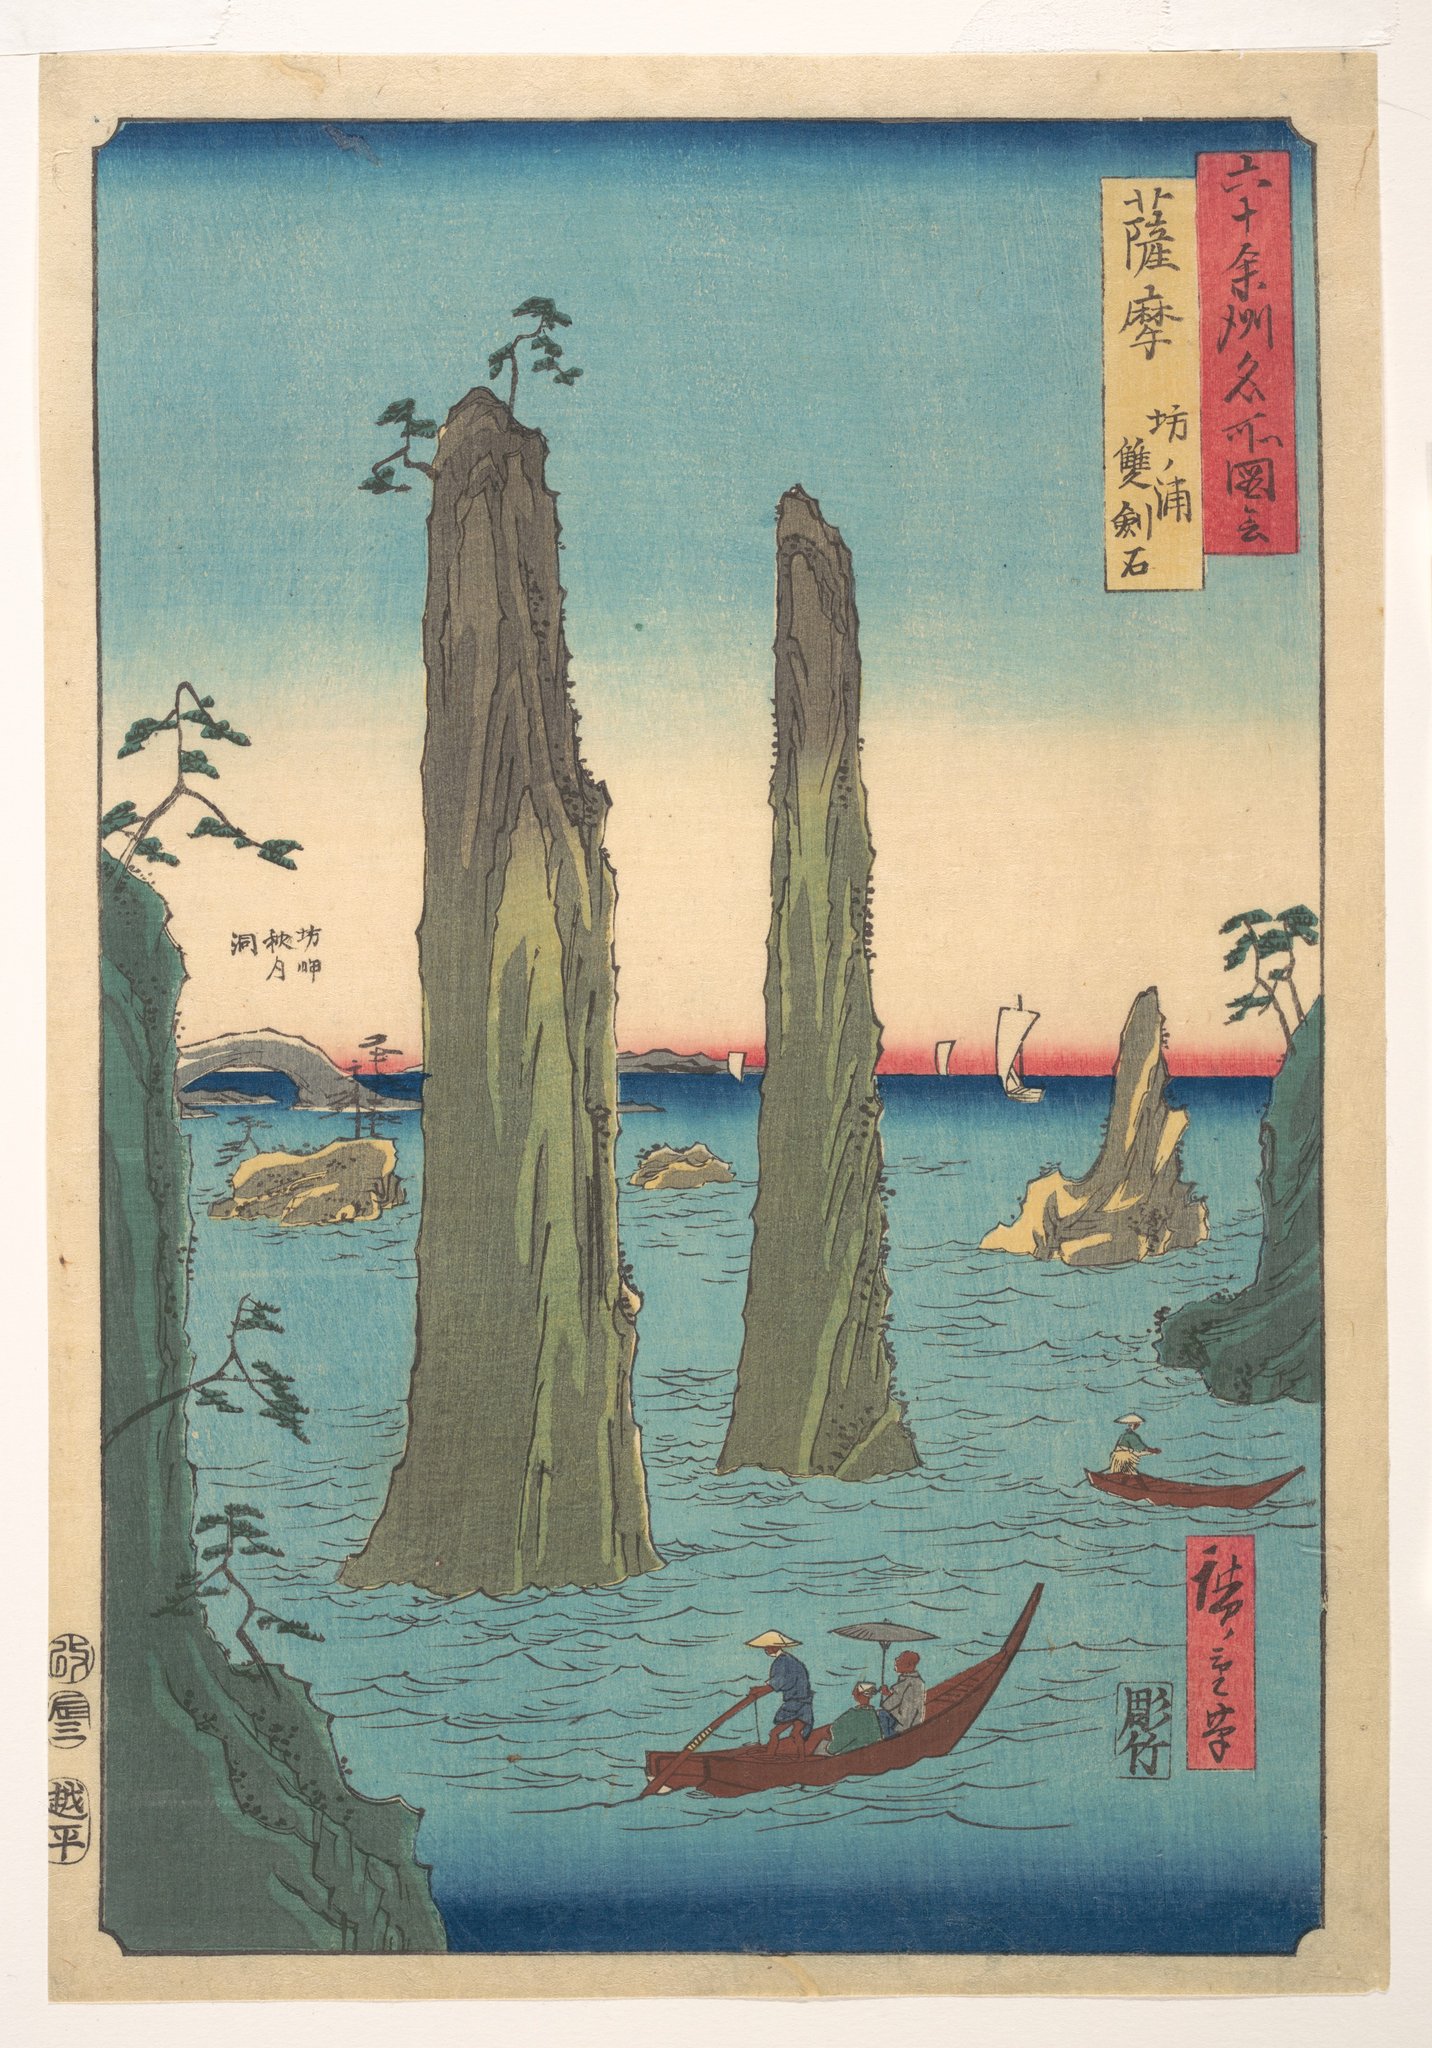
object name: print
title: Upright Landscape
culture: japanese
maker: utagawa hiroshige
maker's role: artist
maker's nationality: japanese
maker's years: 1797-1858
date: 1801-1900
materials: ink, paper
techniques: woodblock print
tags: sailing,landscapes,plants,boats